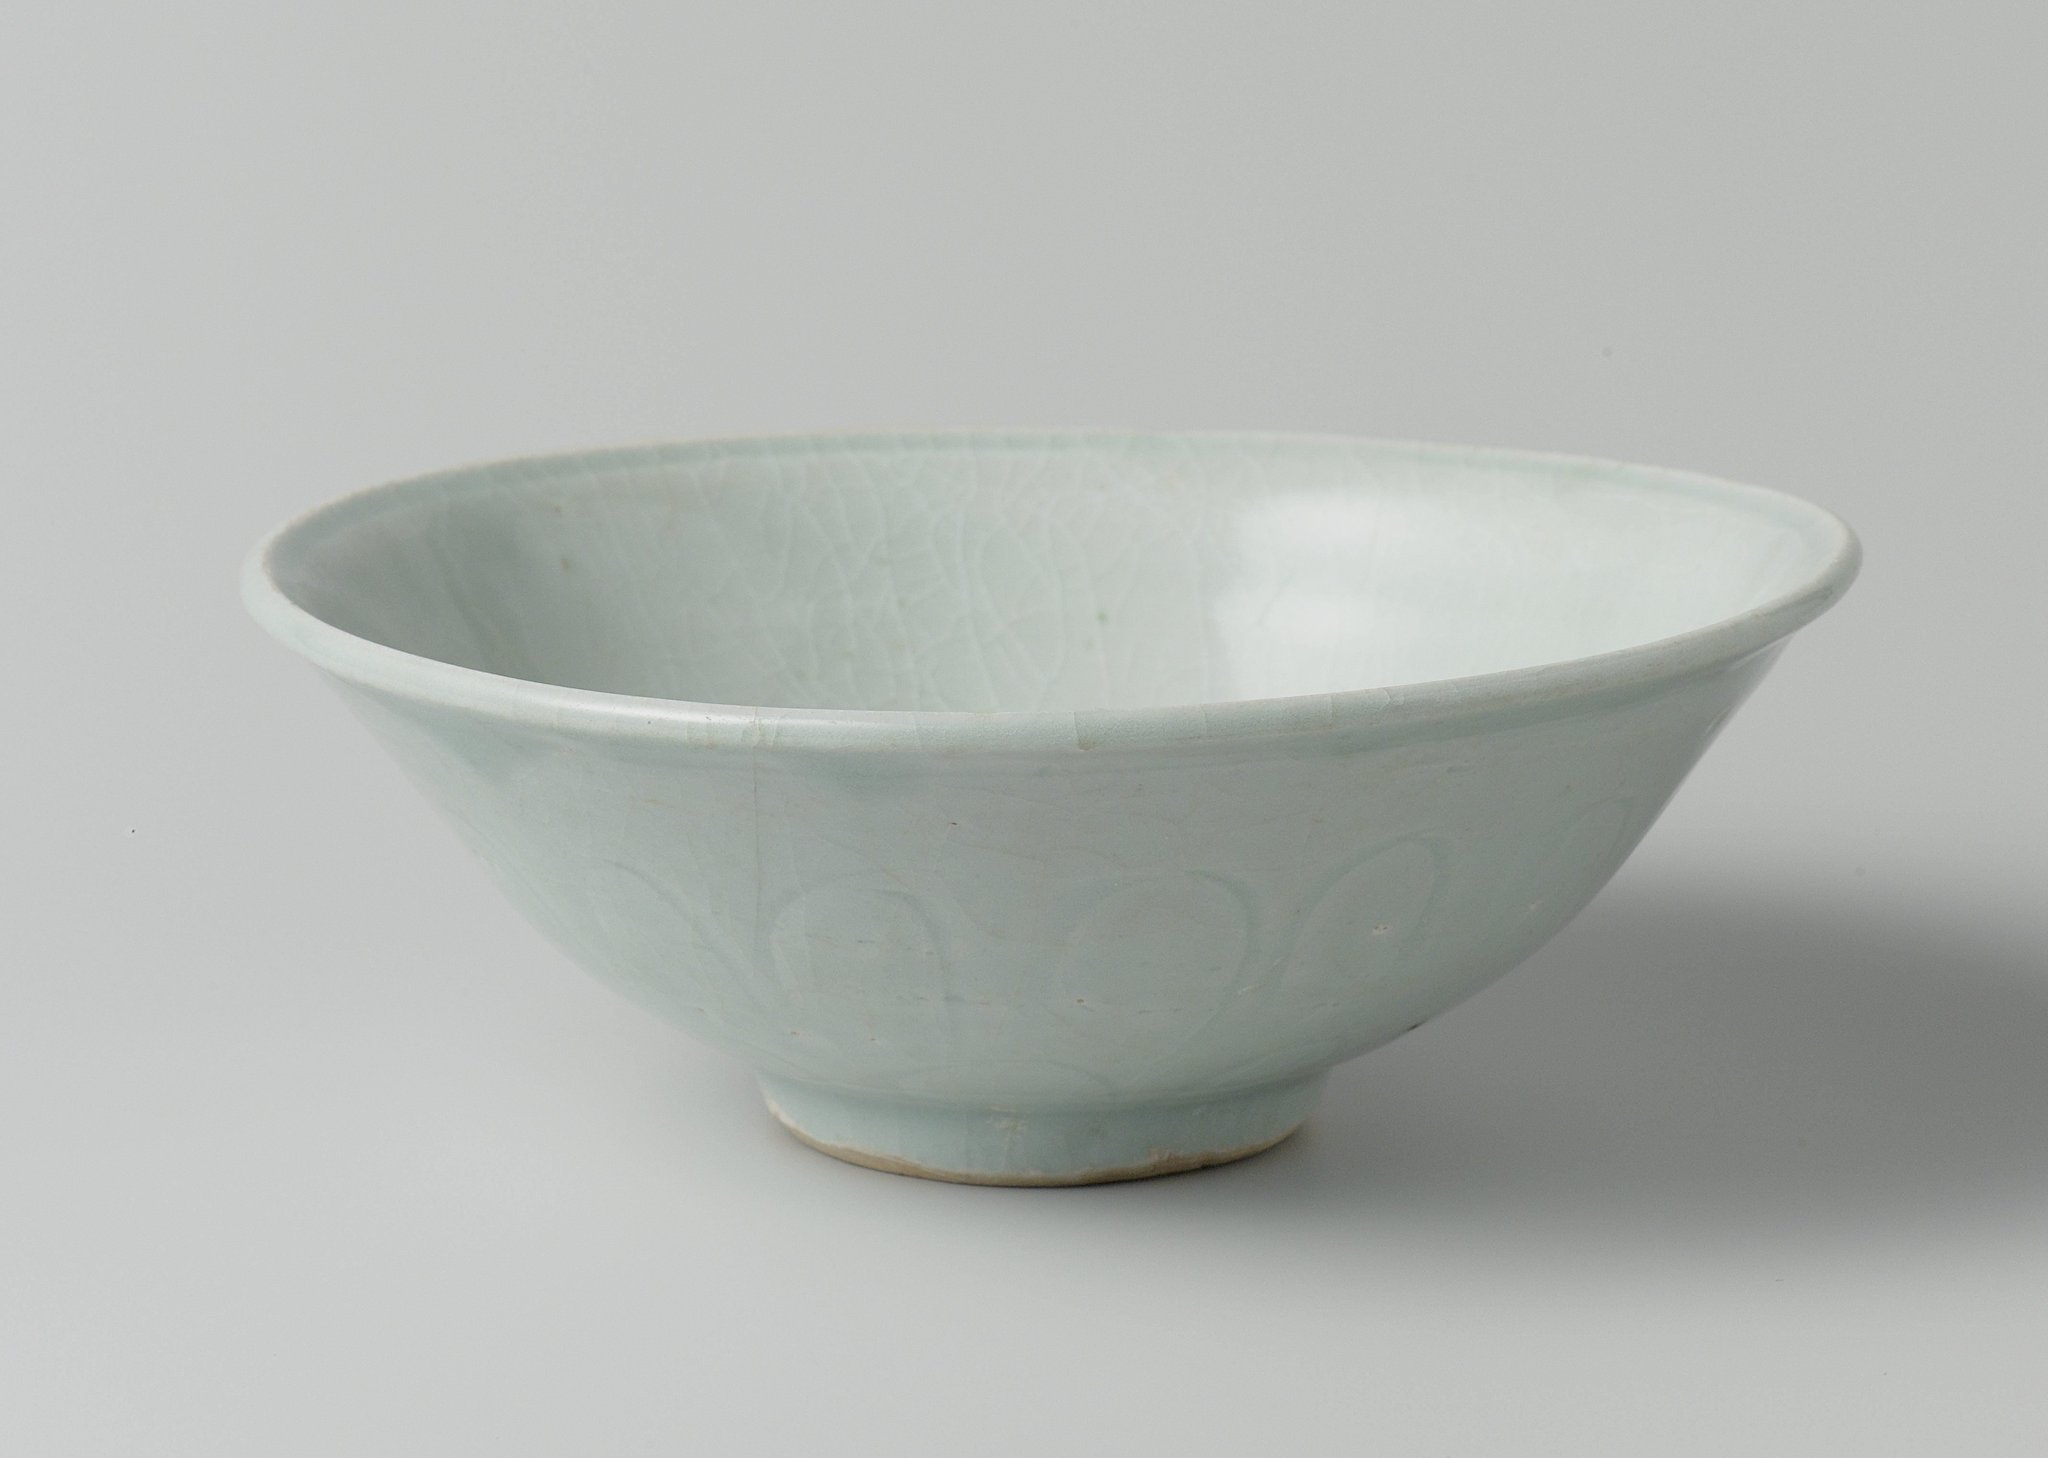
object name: bowl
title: Bell-shaped bowl with an incised crane and lotus plant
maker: Anonymous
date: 1279-1368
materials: glaze, stoneware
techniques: engraving, firing, turning, vitrification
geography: china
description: Klokvormige kom van steengoed, bedekt met een gecraqueleerd transparant glazuur met een lichtblauwe tint. De binnenzijde van de kom met een ingegrifte kraanvogel op water en een lotusplant. Op de buitenwand twee rijen met bloembladeren. Qingbai.